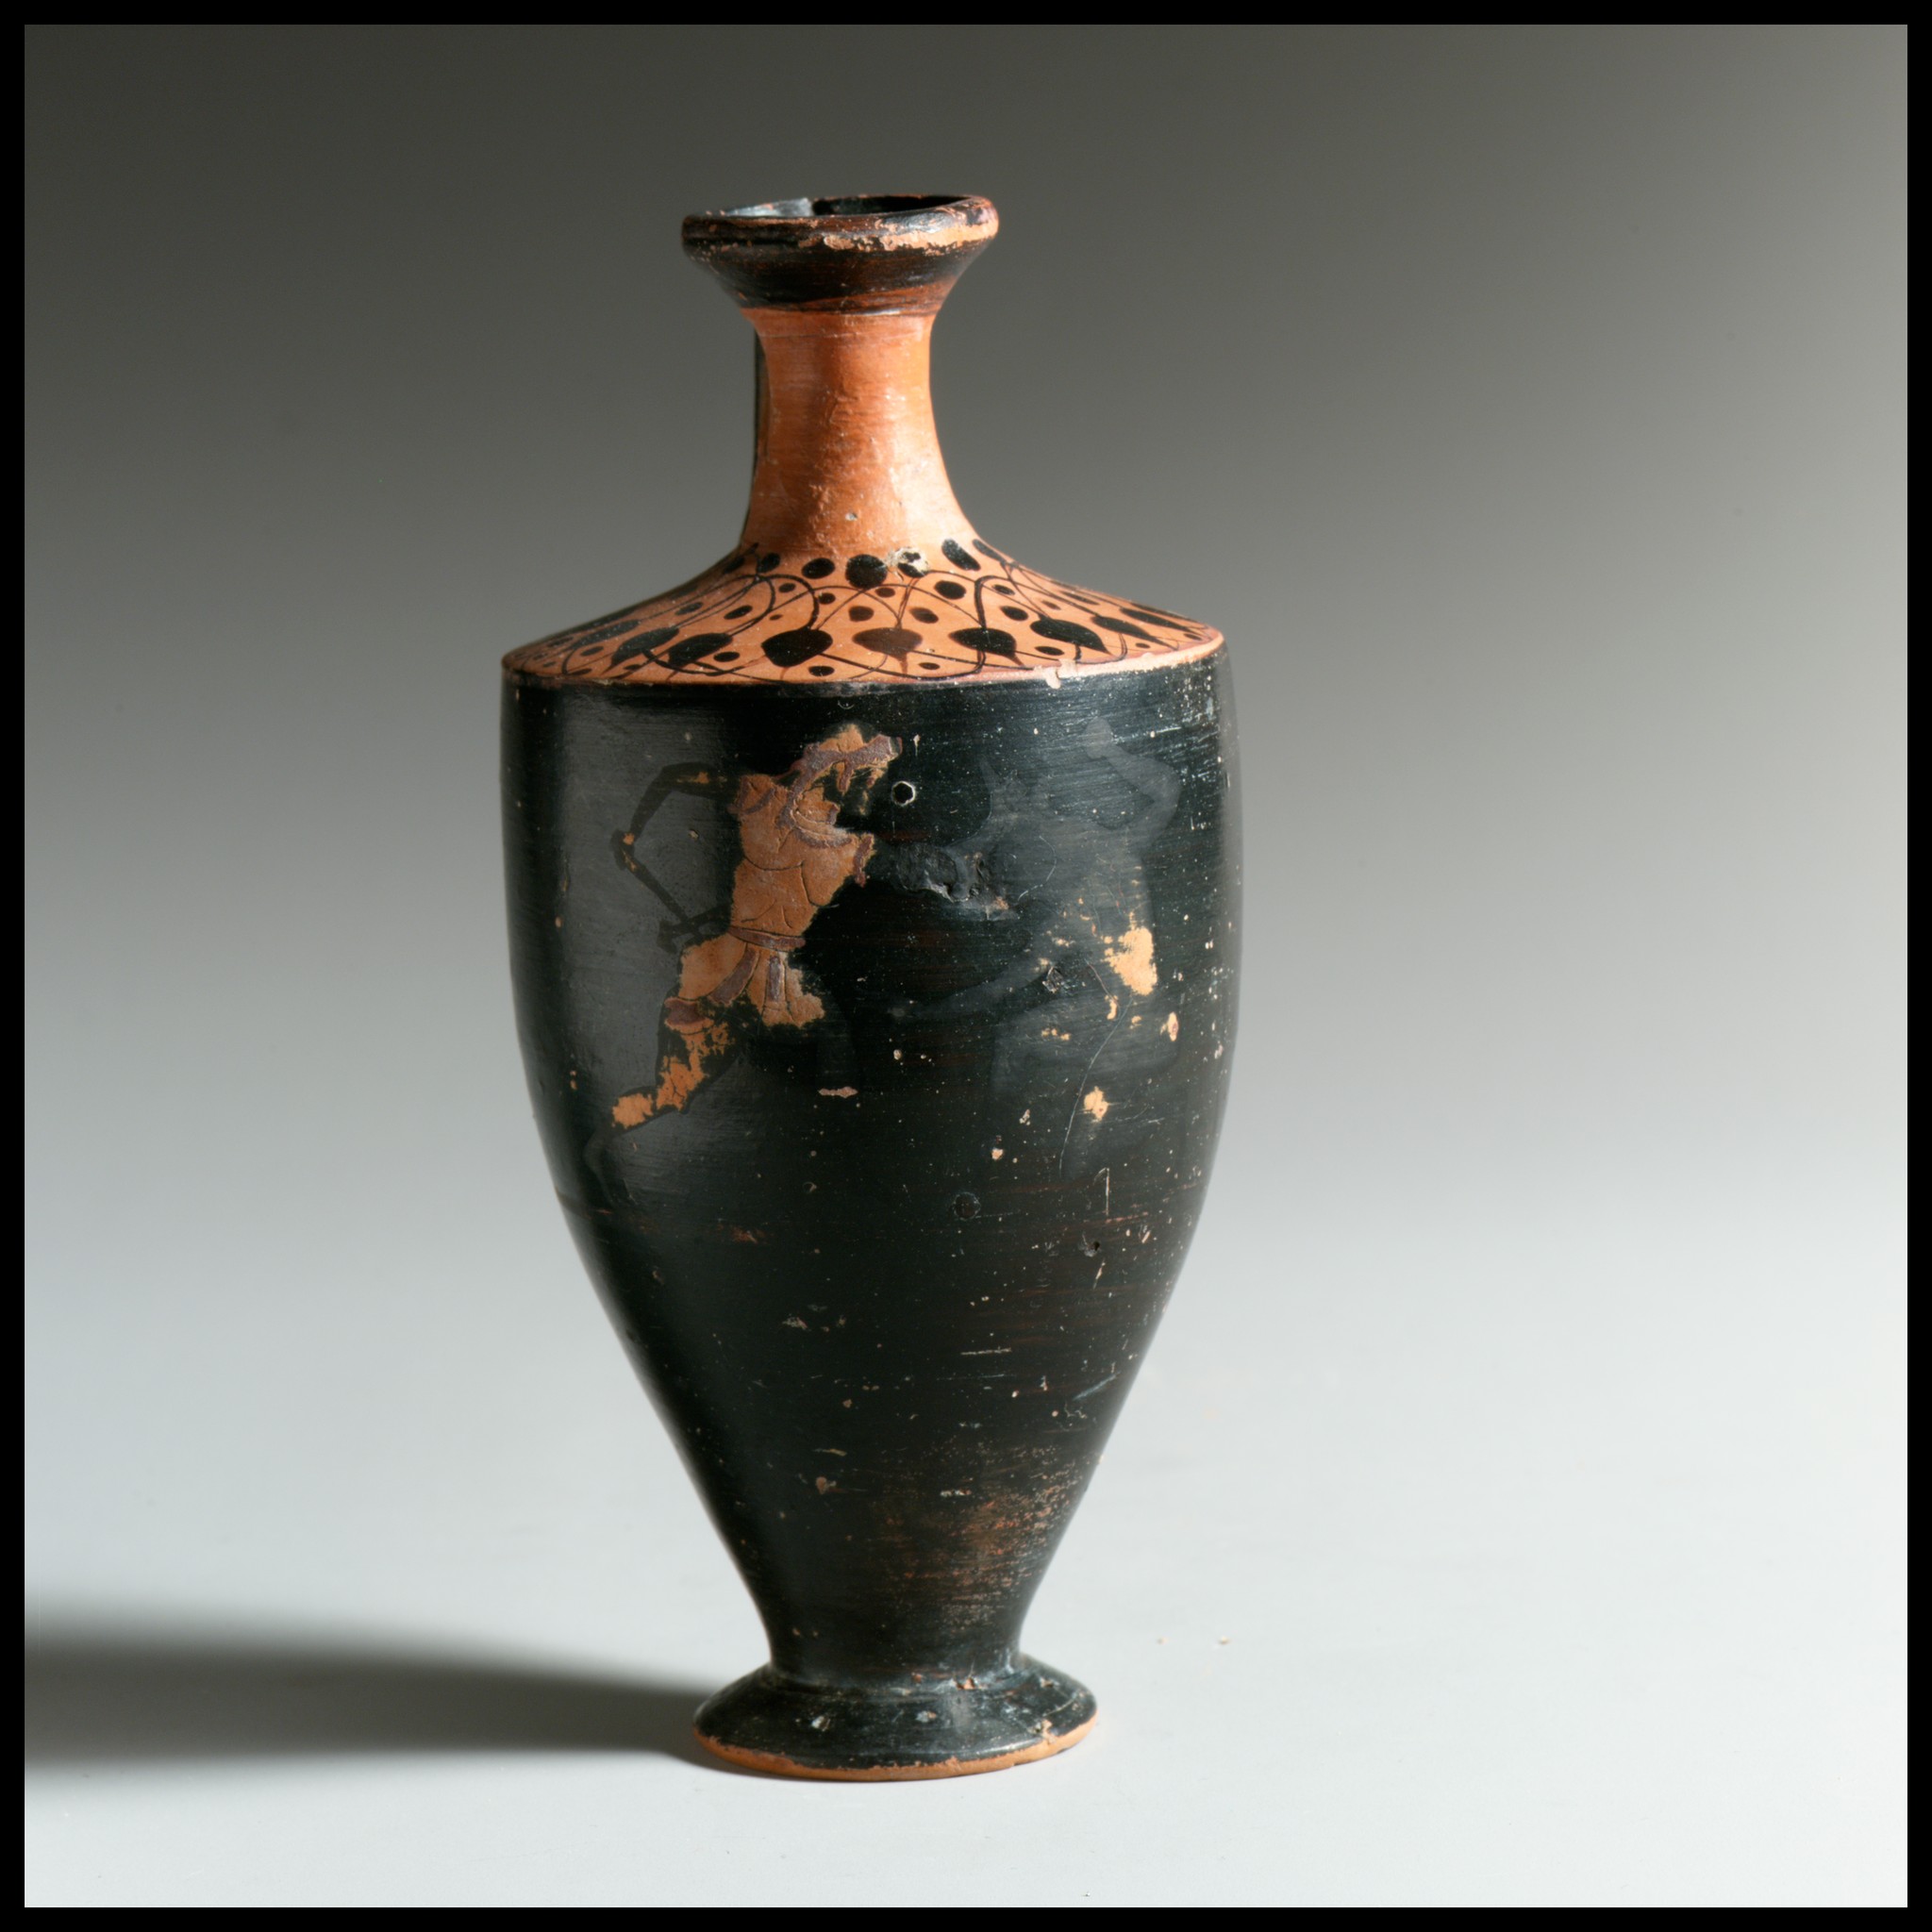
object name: lekythos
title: Terracotta lekythos (oil flask)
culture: greek, attic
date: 550-501 BCE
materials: terracotta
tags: theseus,minotaurs